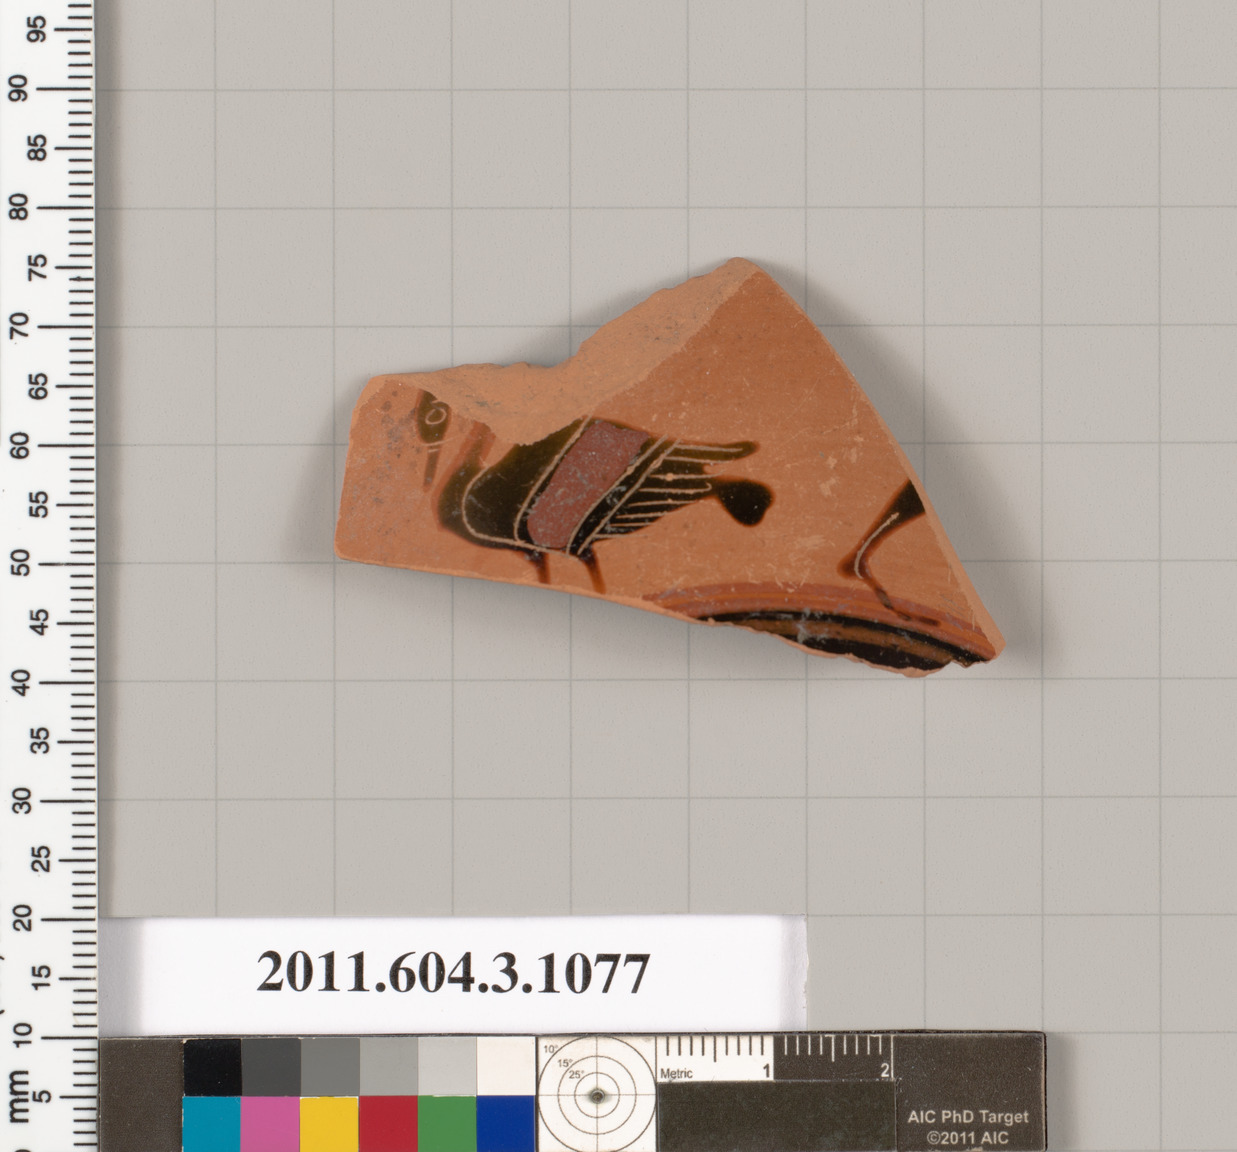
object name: mastoid fragment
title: Terracotta fragment of a mastoid (drinking cup with narrow base)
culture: greek, attic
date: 534-468 BCE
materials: terracotta